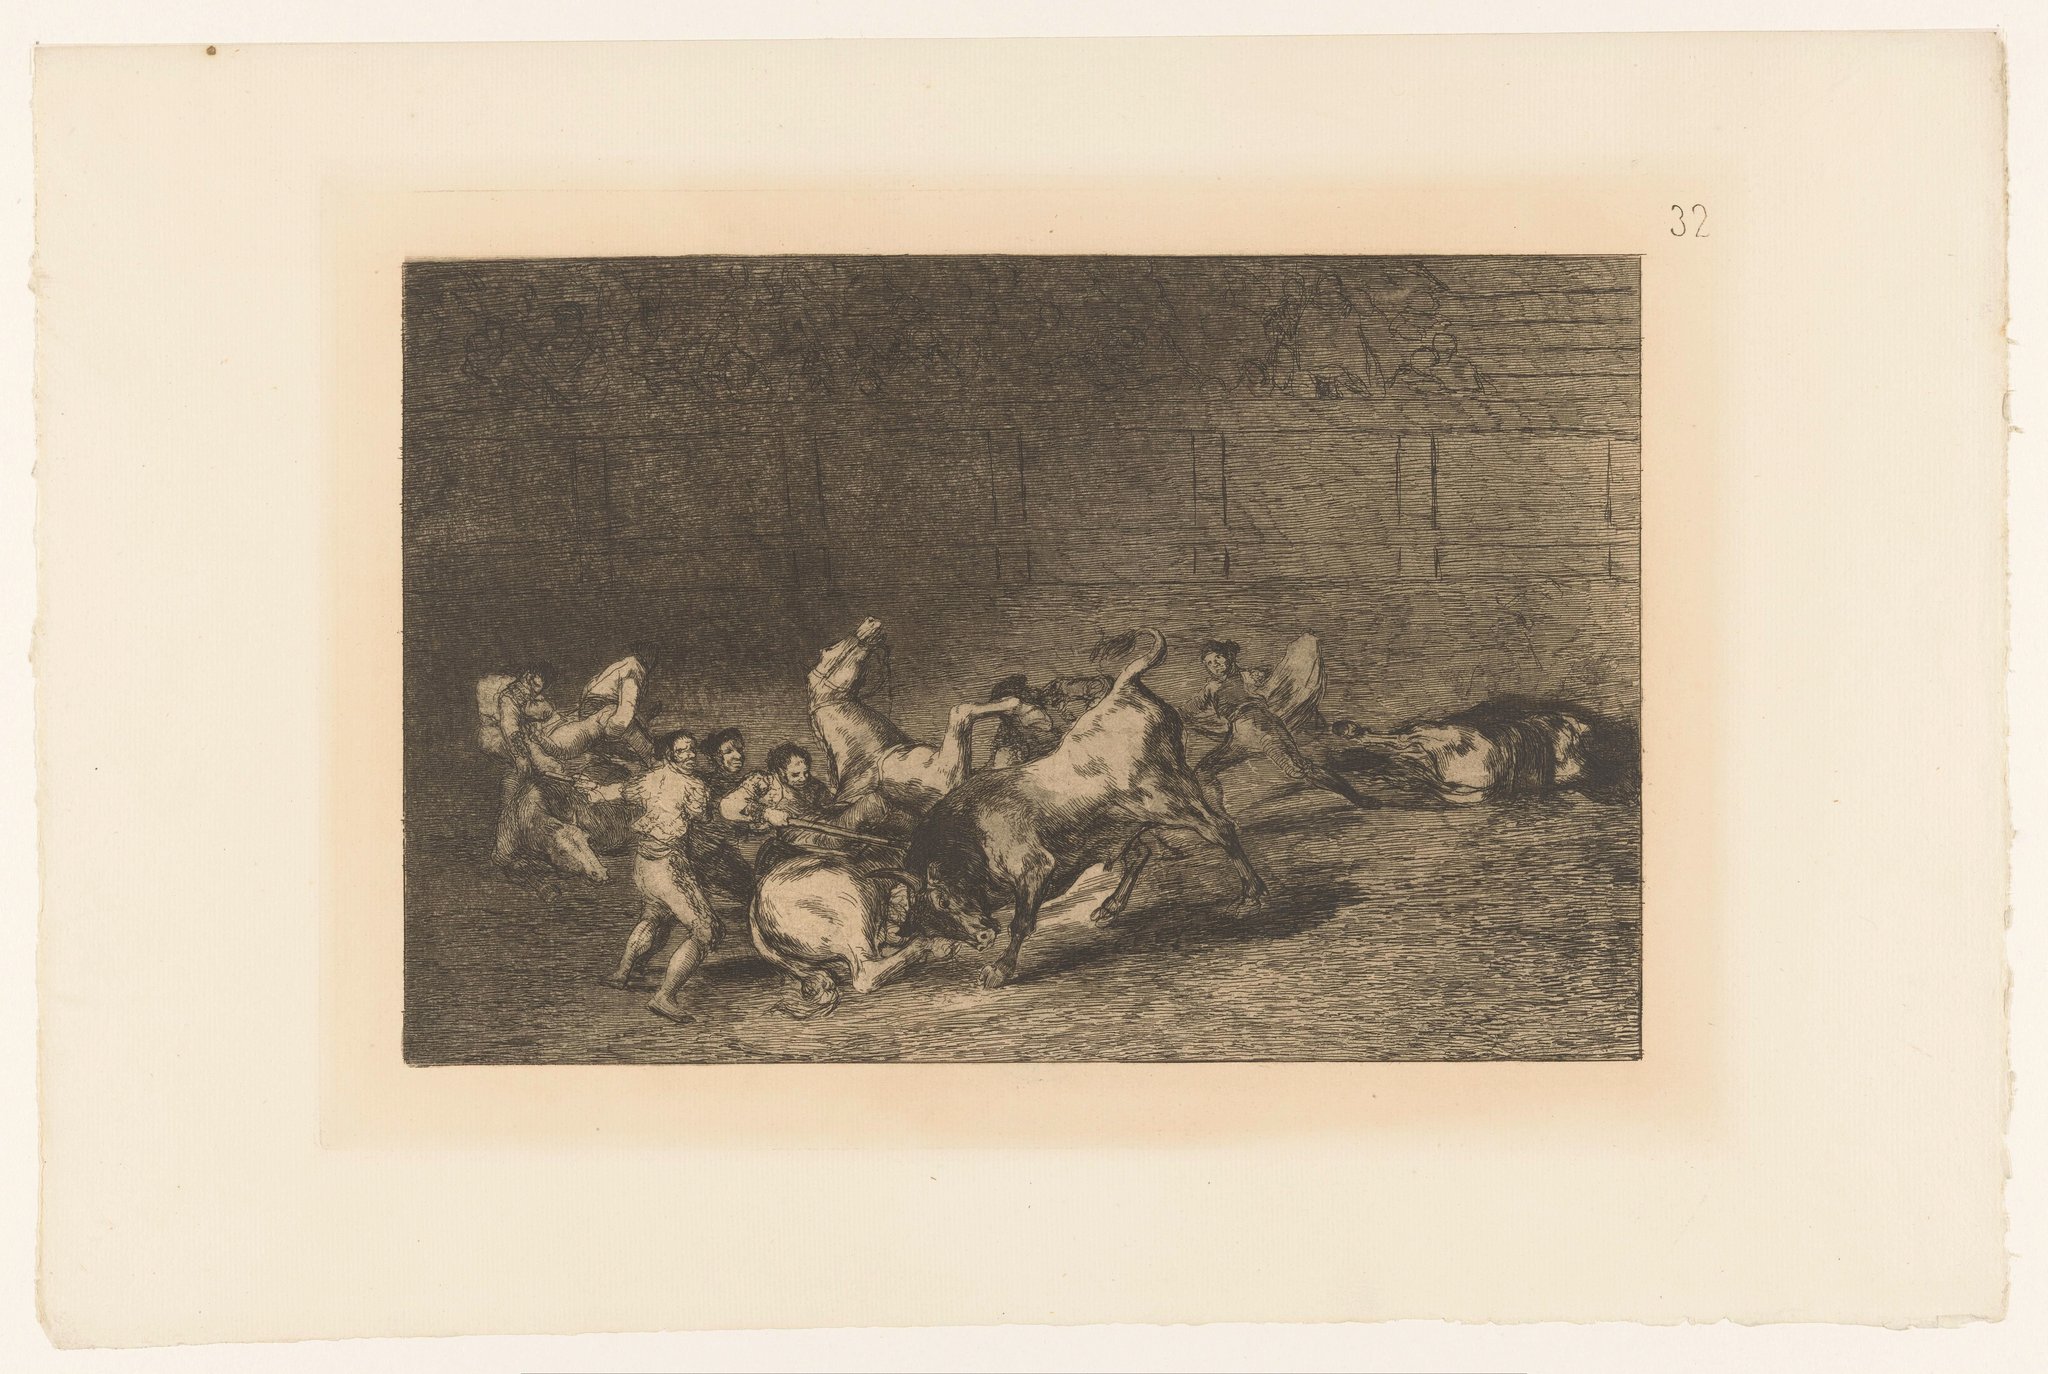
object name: print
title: Dos grupos de picadores arrollados de seguida por un solo toro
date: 1876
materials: paper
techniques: aquatint, etching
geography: paris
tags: bullfight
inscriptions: collector's mark: Lugt 2228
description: Deze prent maakt deel uit van een serie van 40 prenten door Francisco de Goya met voorstellingen van stierengevechten. De eerste editie bestond uit 33 genummerde prenten en werd uitgegeven in 1816. Dit betreft de derde editie, uitgegeven in 1876 door Eugène Loizelet en door hem voorzien van een titelprent en lijst met titels. Naast de 33 prenten publiceerde Loizelet ook de prenten die door Goya op de achterkanten van 7 van de platen werden geëtst. Deze zijn niet voorzien van nummers maar van de letters A-G.